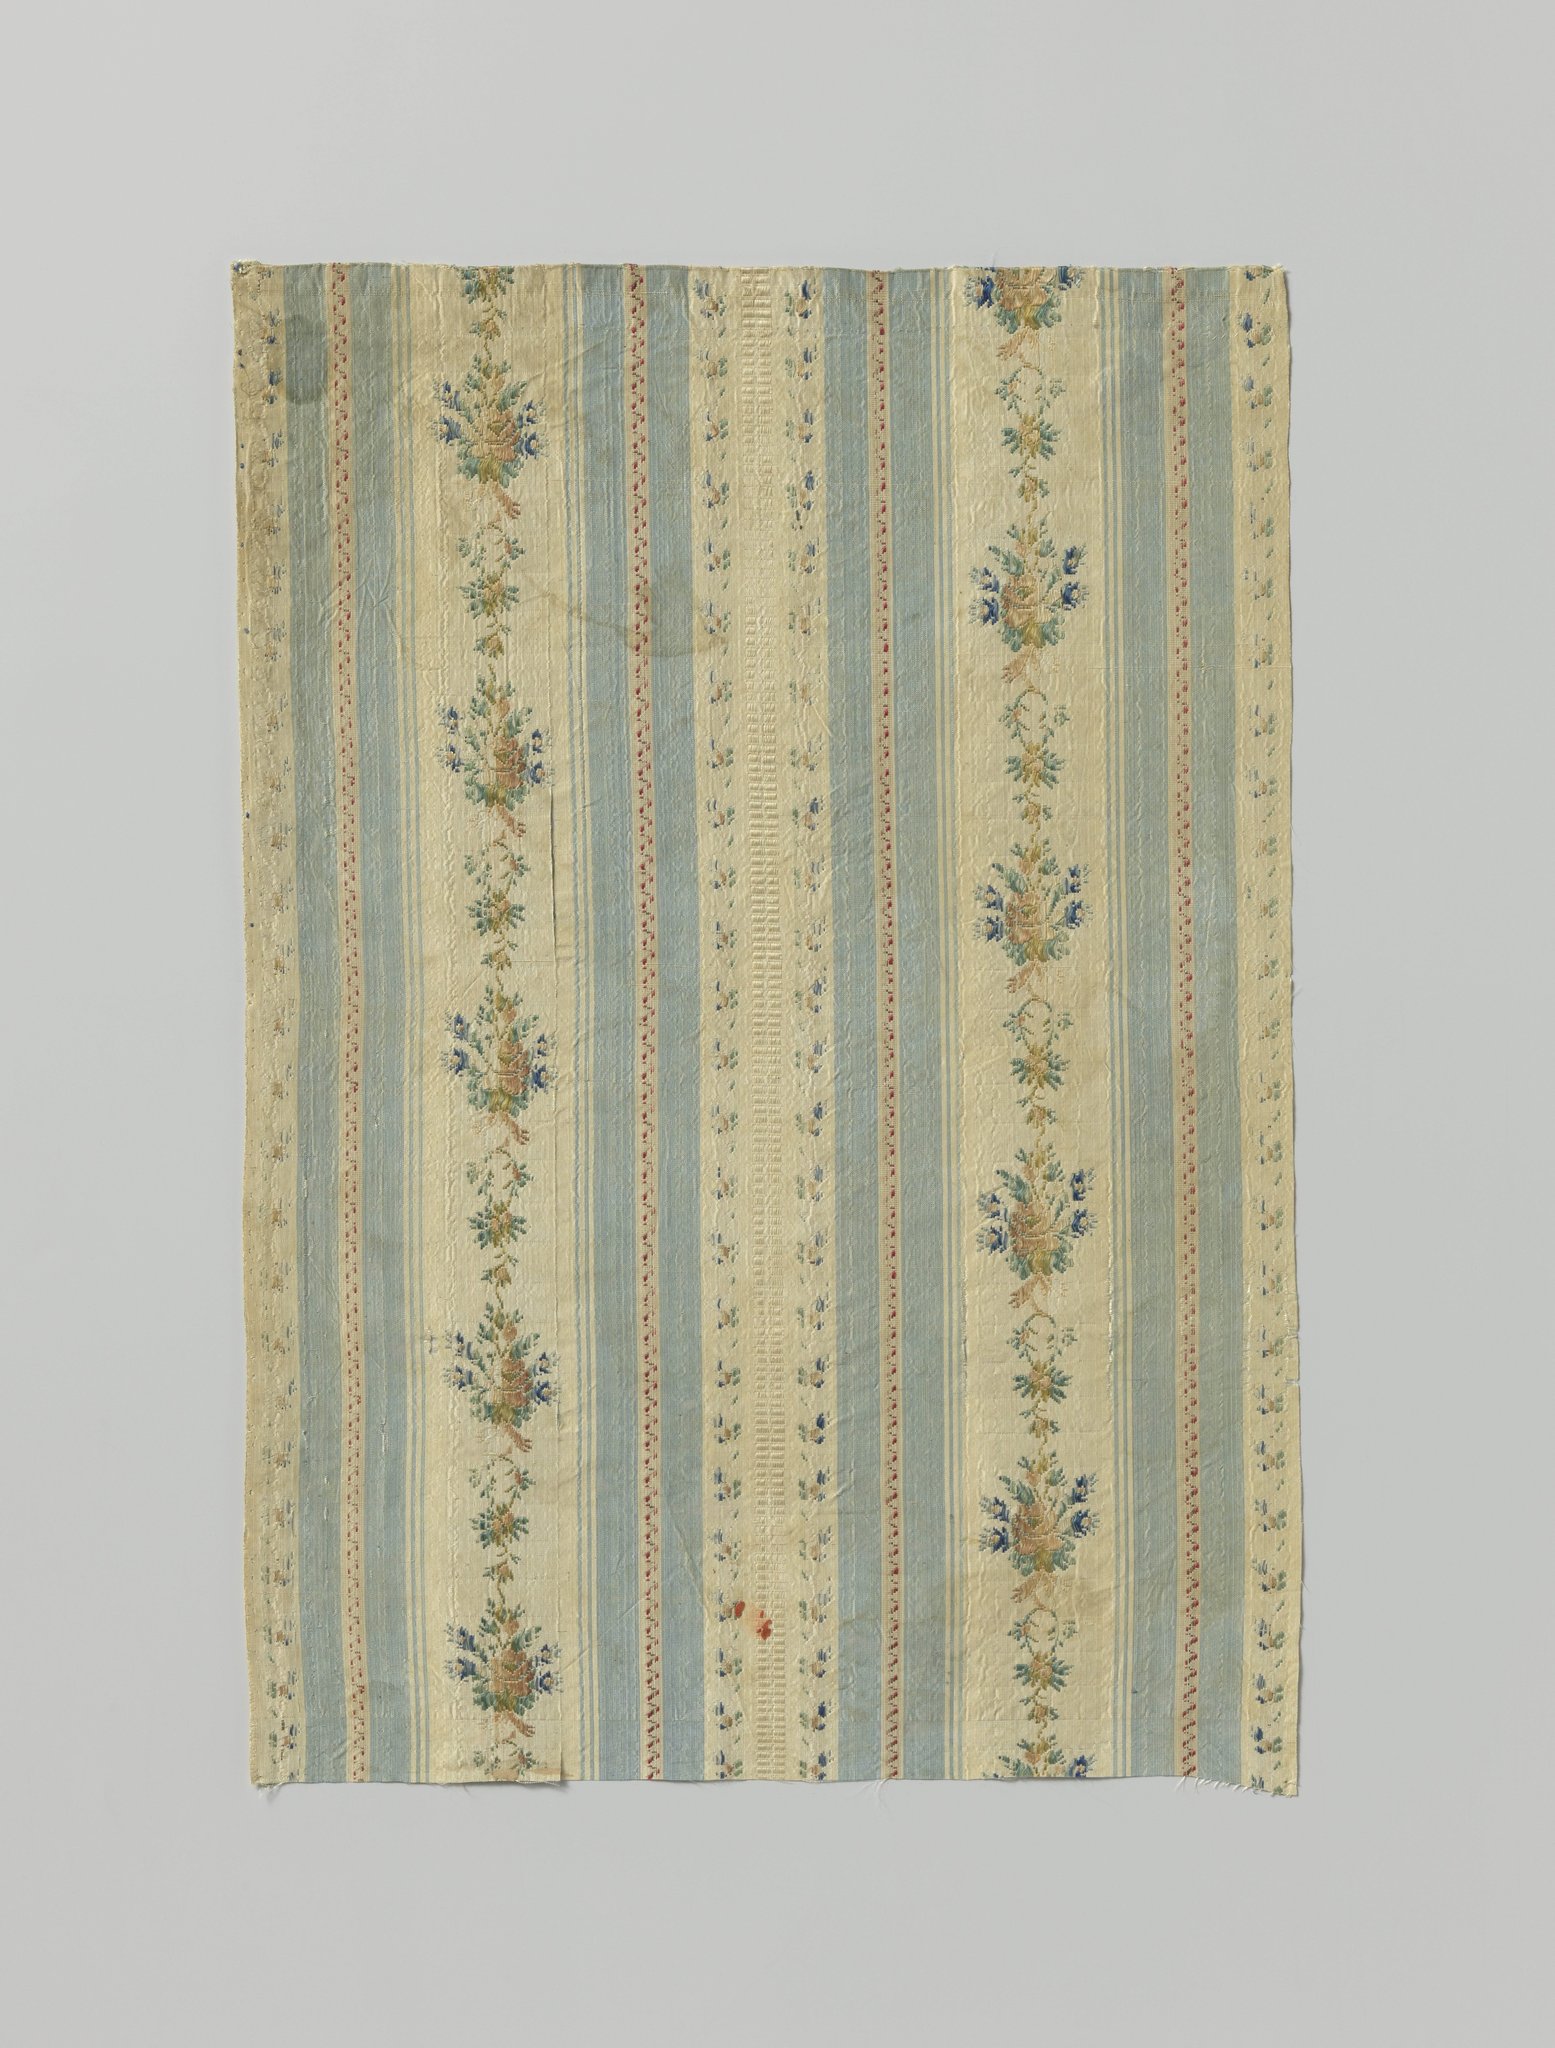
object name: fragment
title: Fragment veelkleurig, gestreept zijden pekin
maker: Anonymous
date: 1750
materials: silk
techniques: gadrooning, weave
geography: france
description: Een fragment van blauw en wit gestreepte zijde, waartussen gekleurde boeketten en streepen. Opmerking: 0.2 cm, effenbinding.